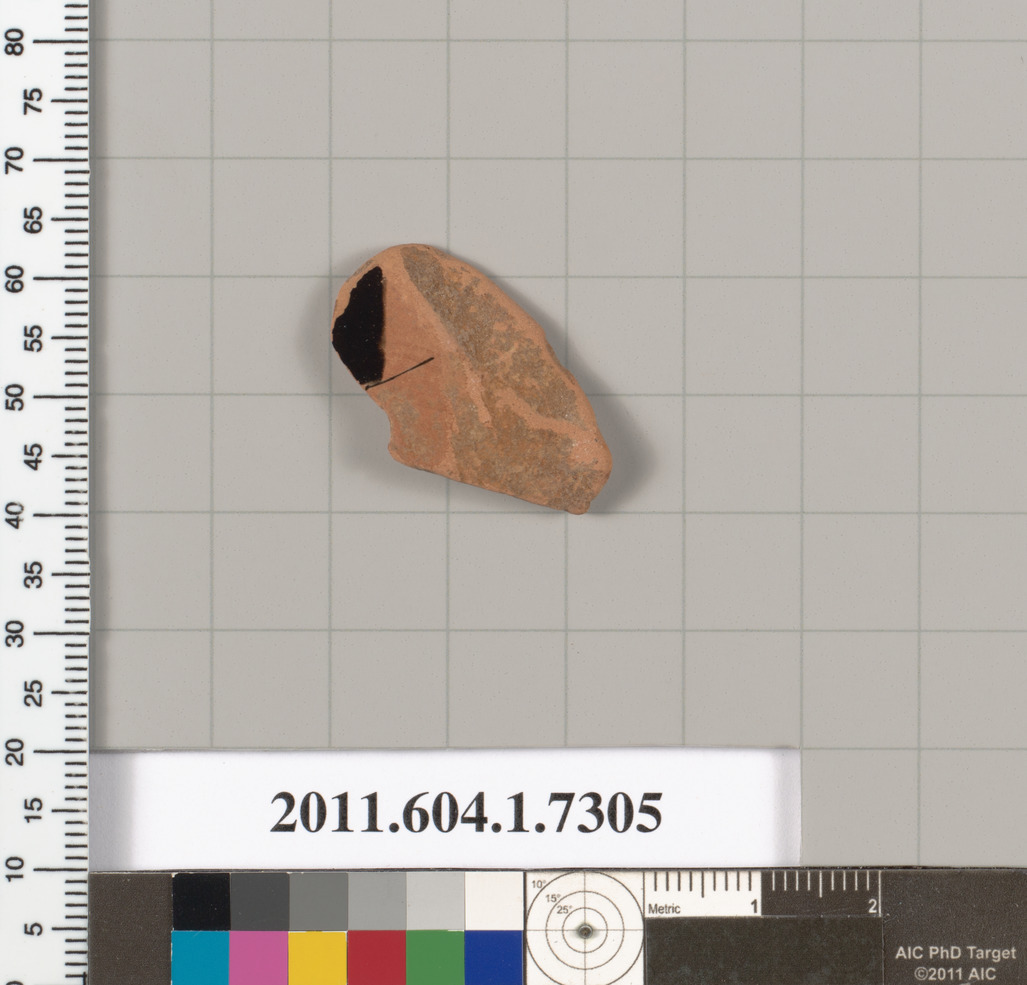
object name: kylix fragment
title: Terracotta fragment of a kylix (drinking cup)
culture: greek, attic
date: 500-480 BCE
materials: terracotta